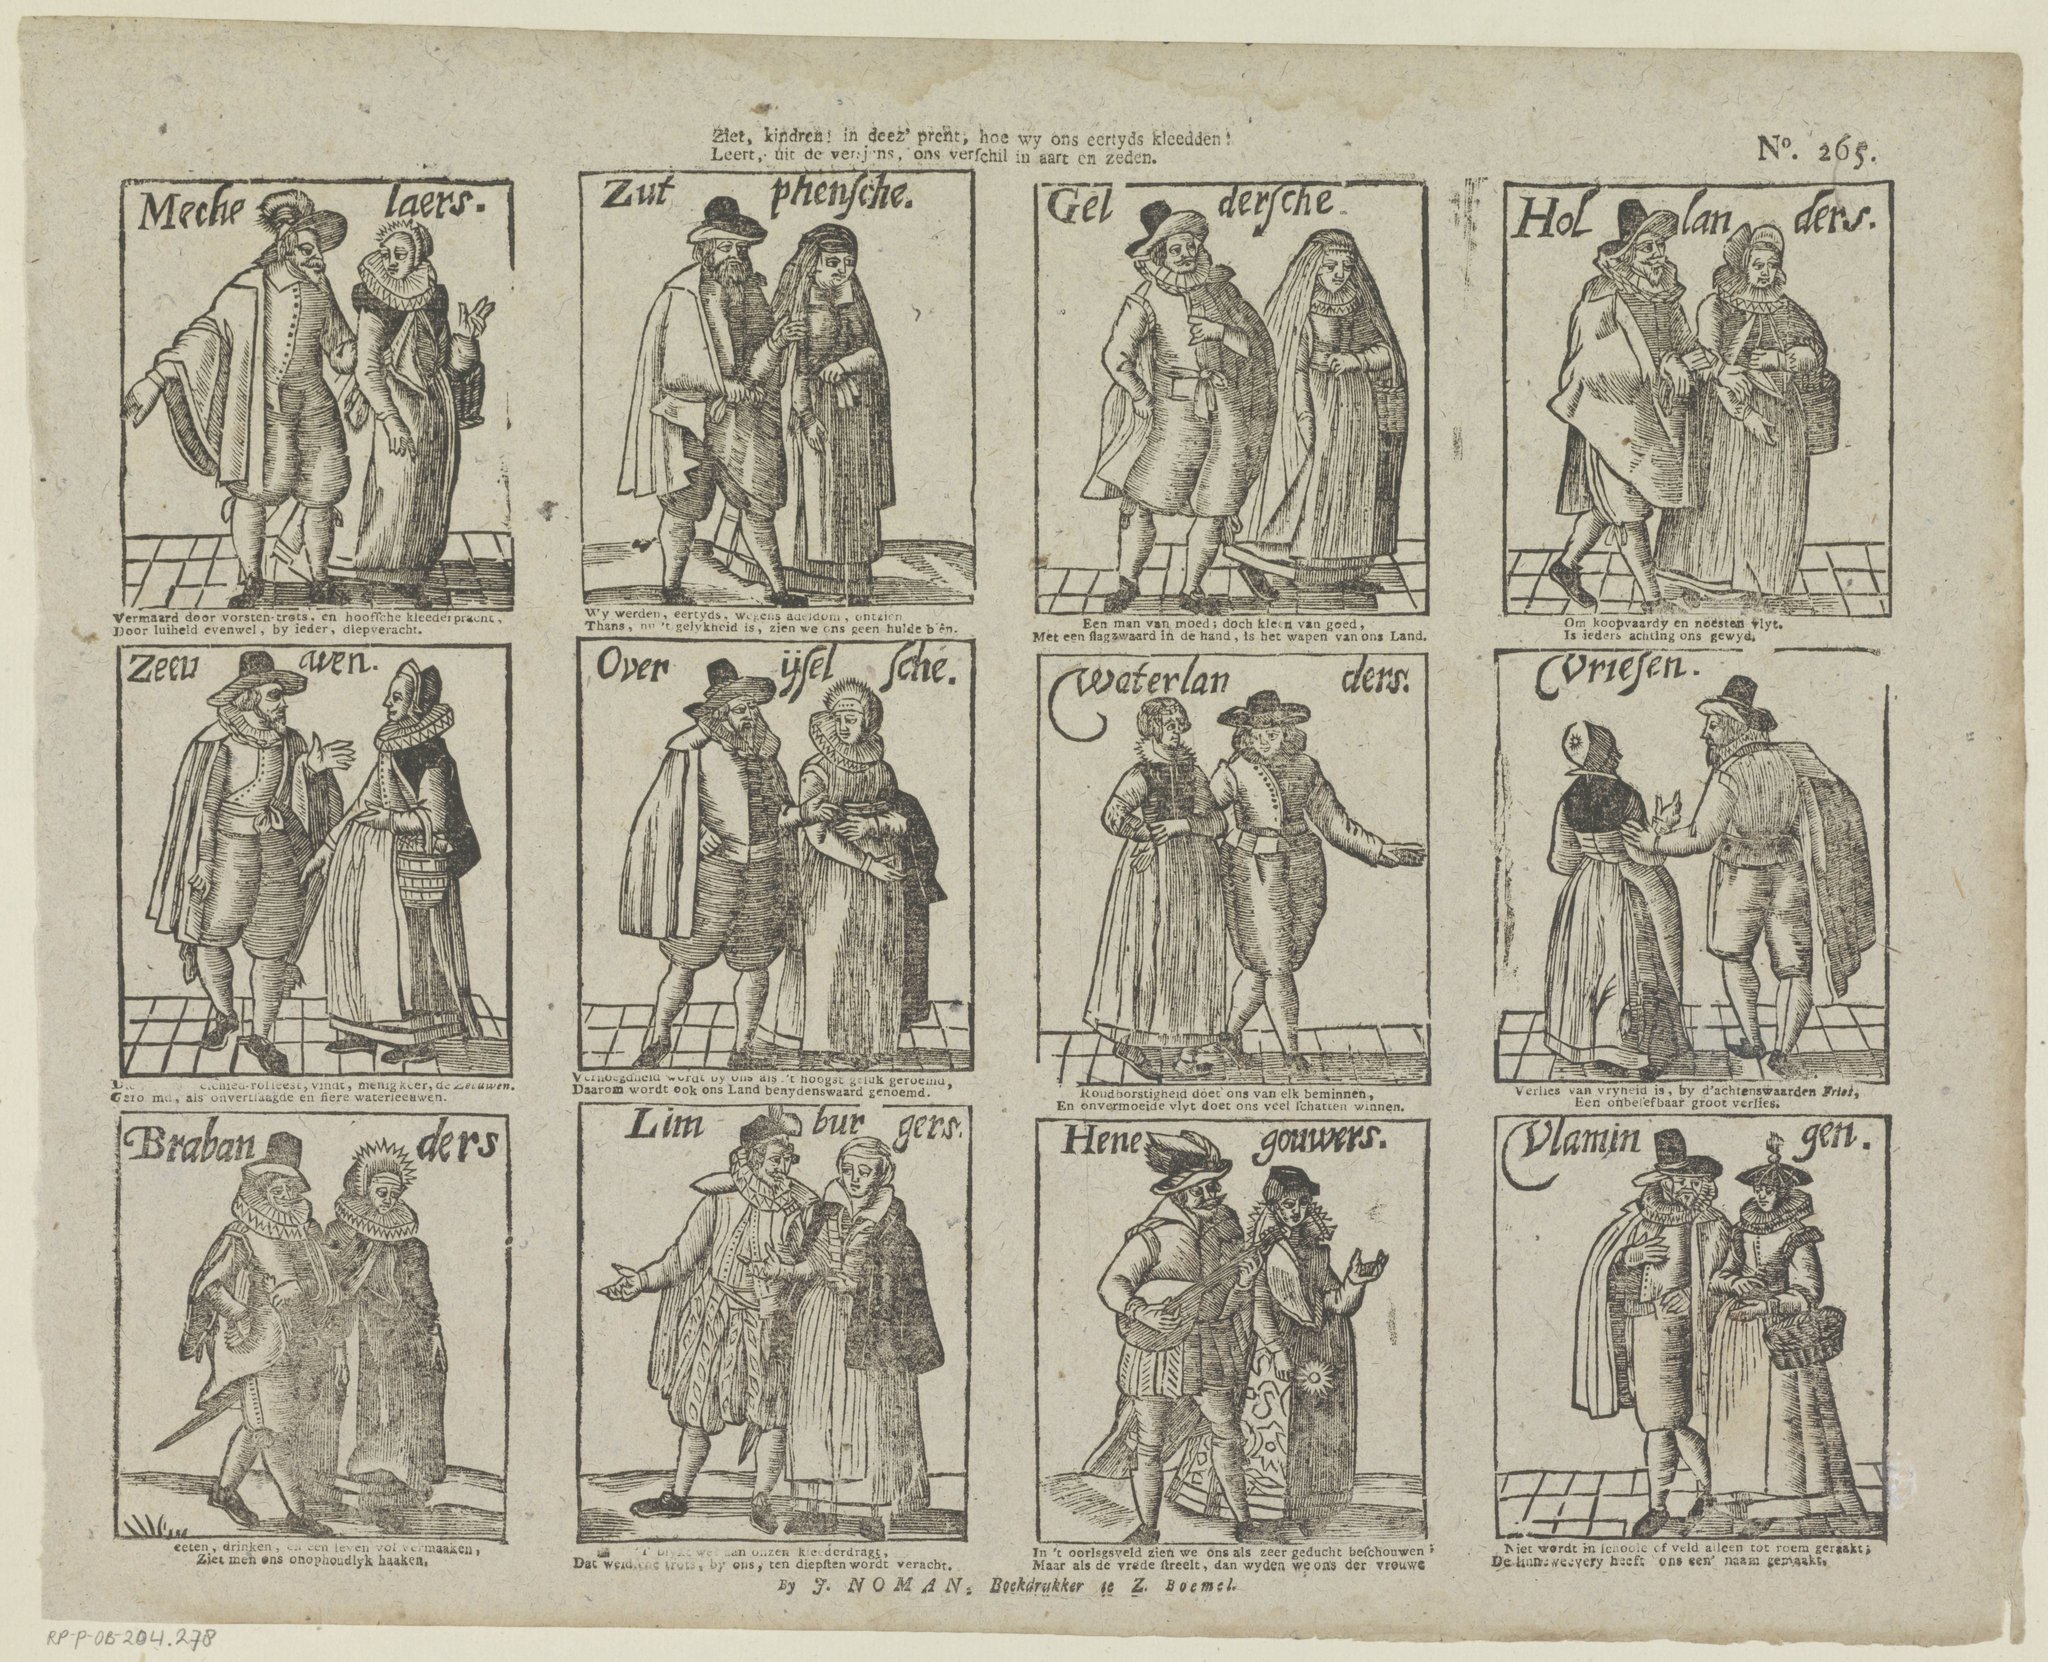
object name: print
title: Ziet, kindren! in deez' prent, hoe wy ons eertyds kleedden: / Leert, uit de versjens, ons verschil in aart en zeden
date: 1806-1830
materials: paper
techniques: letterpress printing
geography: zaltbommel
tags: europeans, historical costume, folk costume, regional costume, zeeland, mechelen, brabant, gelderland, holland, henegouwen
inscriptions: collector's mark: Lugt 2760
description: Blad met 12 voorstellingen van paren uit verschillende streken in diverse klederdrachten. Onder elke afbeelding een tweeregelig vers. In elke afbeelding de naam van de streek of provincie waar het paar vandaan komt. Genummerd rechtsboven: No. 265.